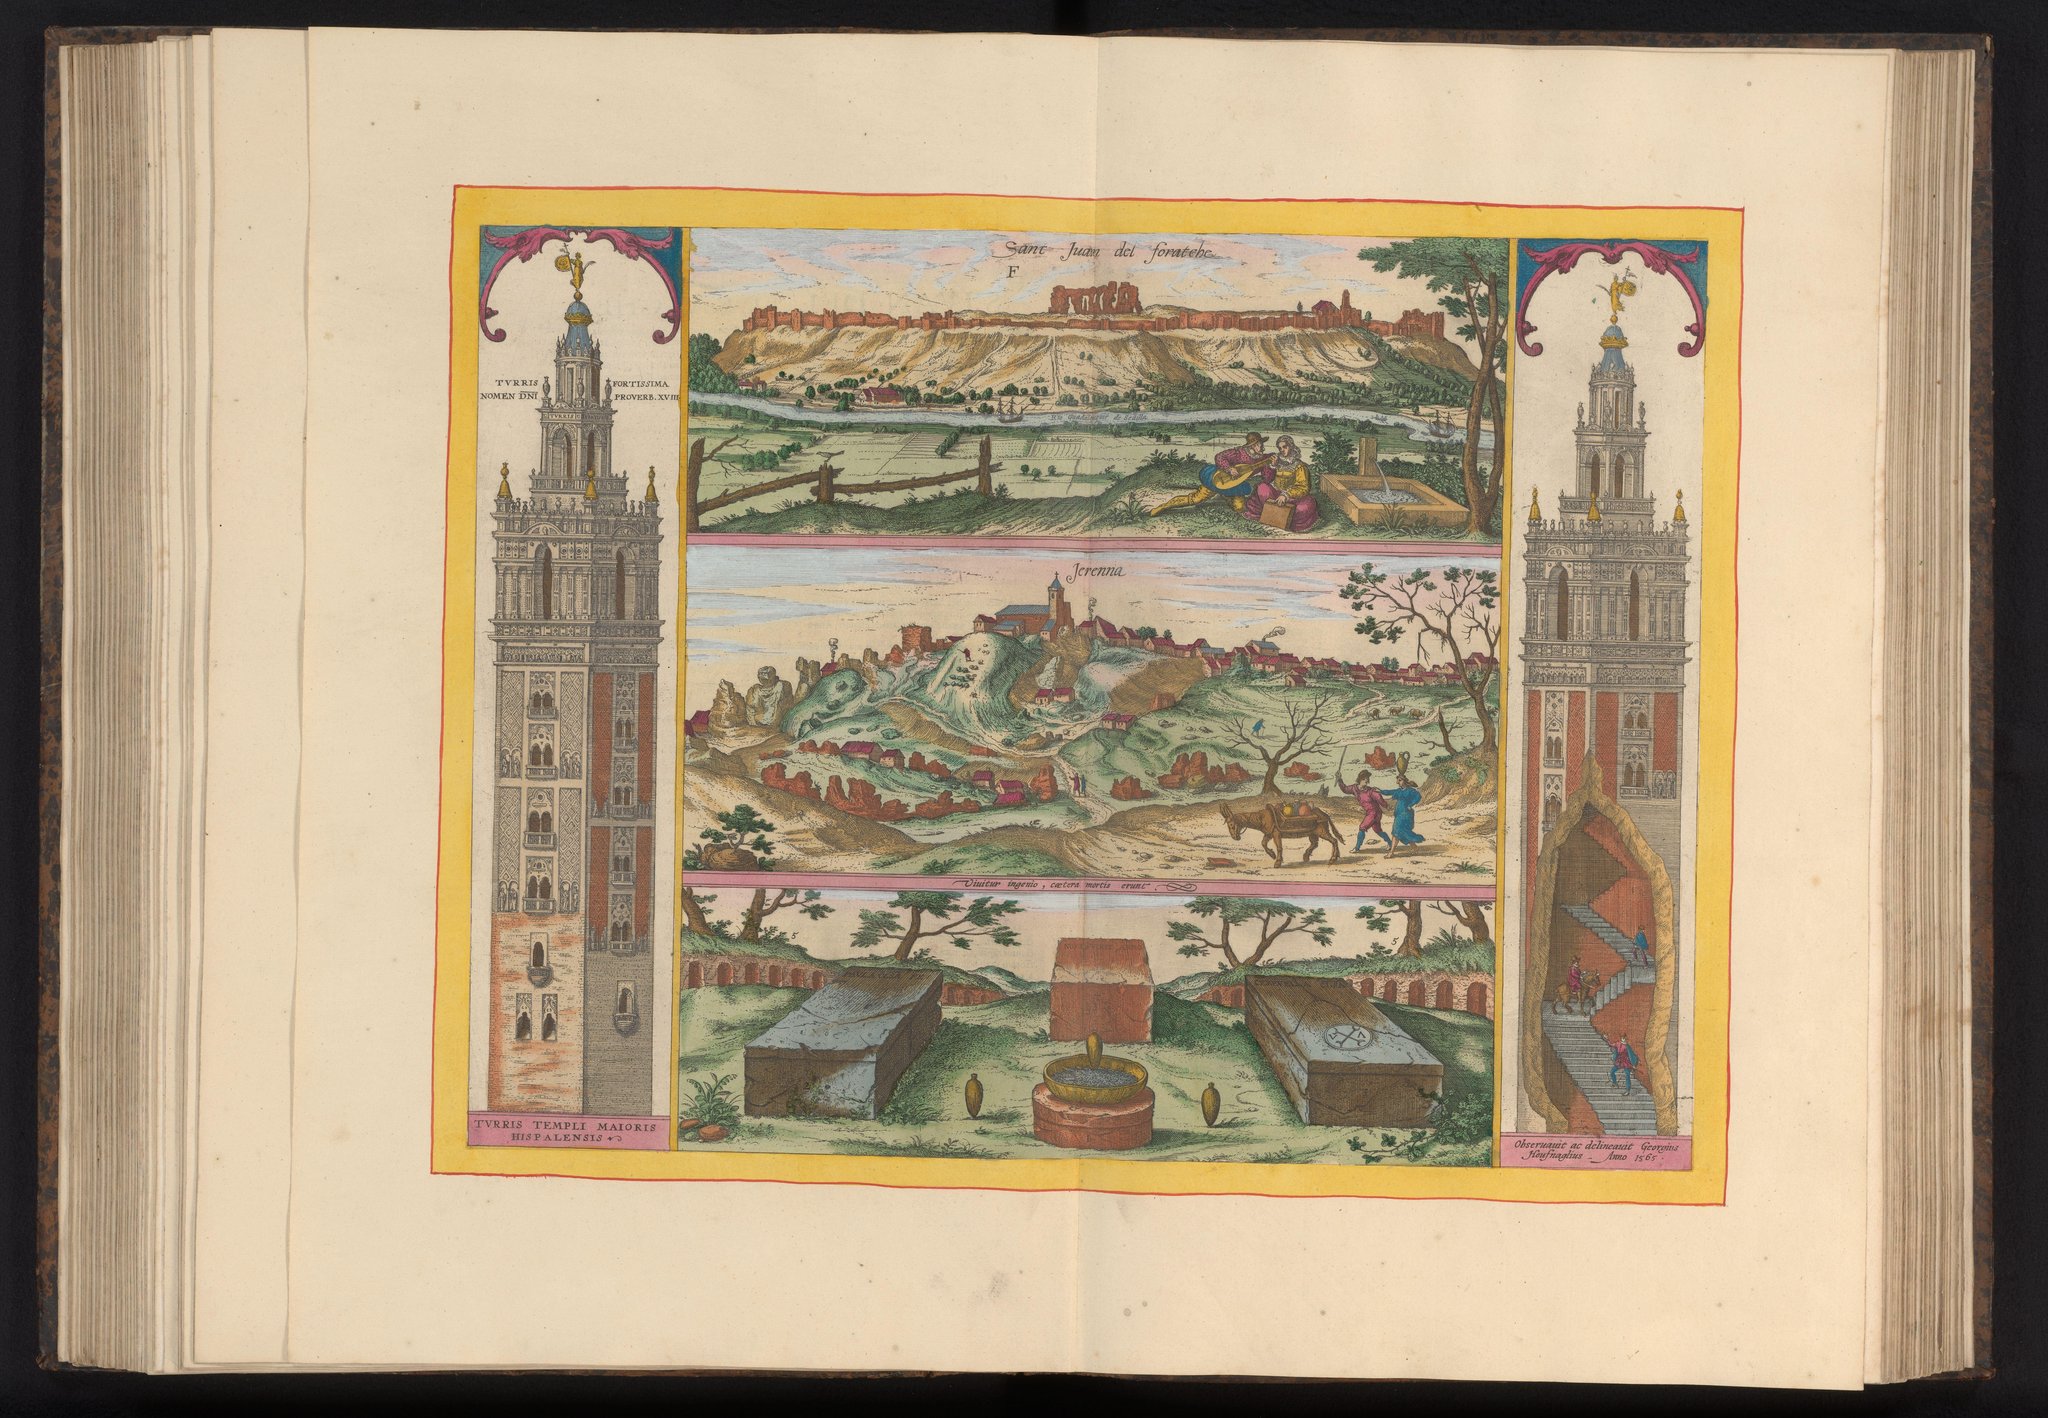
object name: print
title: Sant Juan del foratche / Jerenna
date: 1565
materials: paper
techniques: engraving, etching, hand coloring, letterpress printing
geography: sevilla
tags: tower, clock tower ~ monumental adornment, landscape with ruins, sevilla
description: Prent origineel vervaardigd als boekillustratie voor: Georg Braun en Frans Hogenberg. Civitates Orbis Terrarum, 6 delen. Keulen: 1572-1617. De prent werd voor het eerst gepubliceerd in deel 5: Urbium praecipuarum mundi theatrum quintum, 1596. De prent is langs de bovenrand van de heuvels afgescheurd. Het bovenste gedeelte met de lucht is hoger opgeplakt, zodat de lucht hoger is geworden en het formaat van de voorstelling past bij de andere groot formaatvoorstellingen in het album.